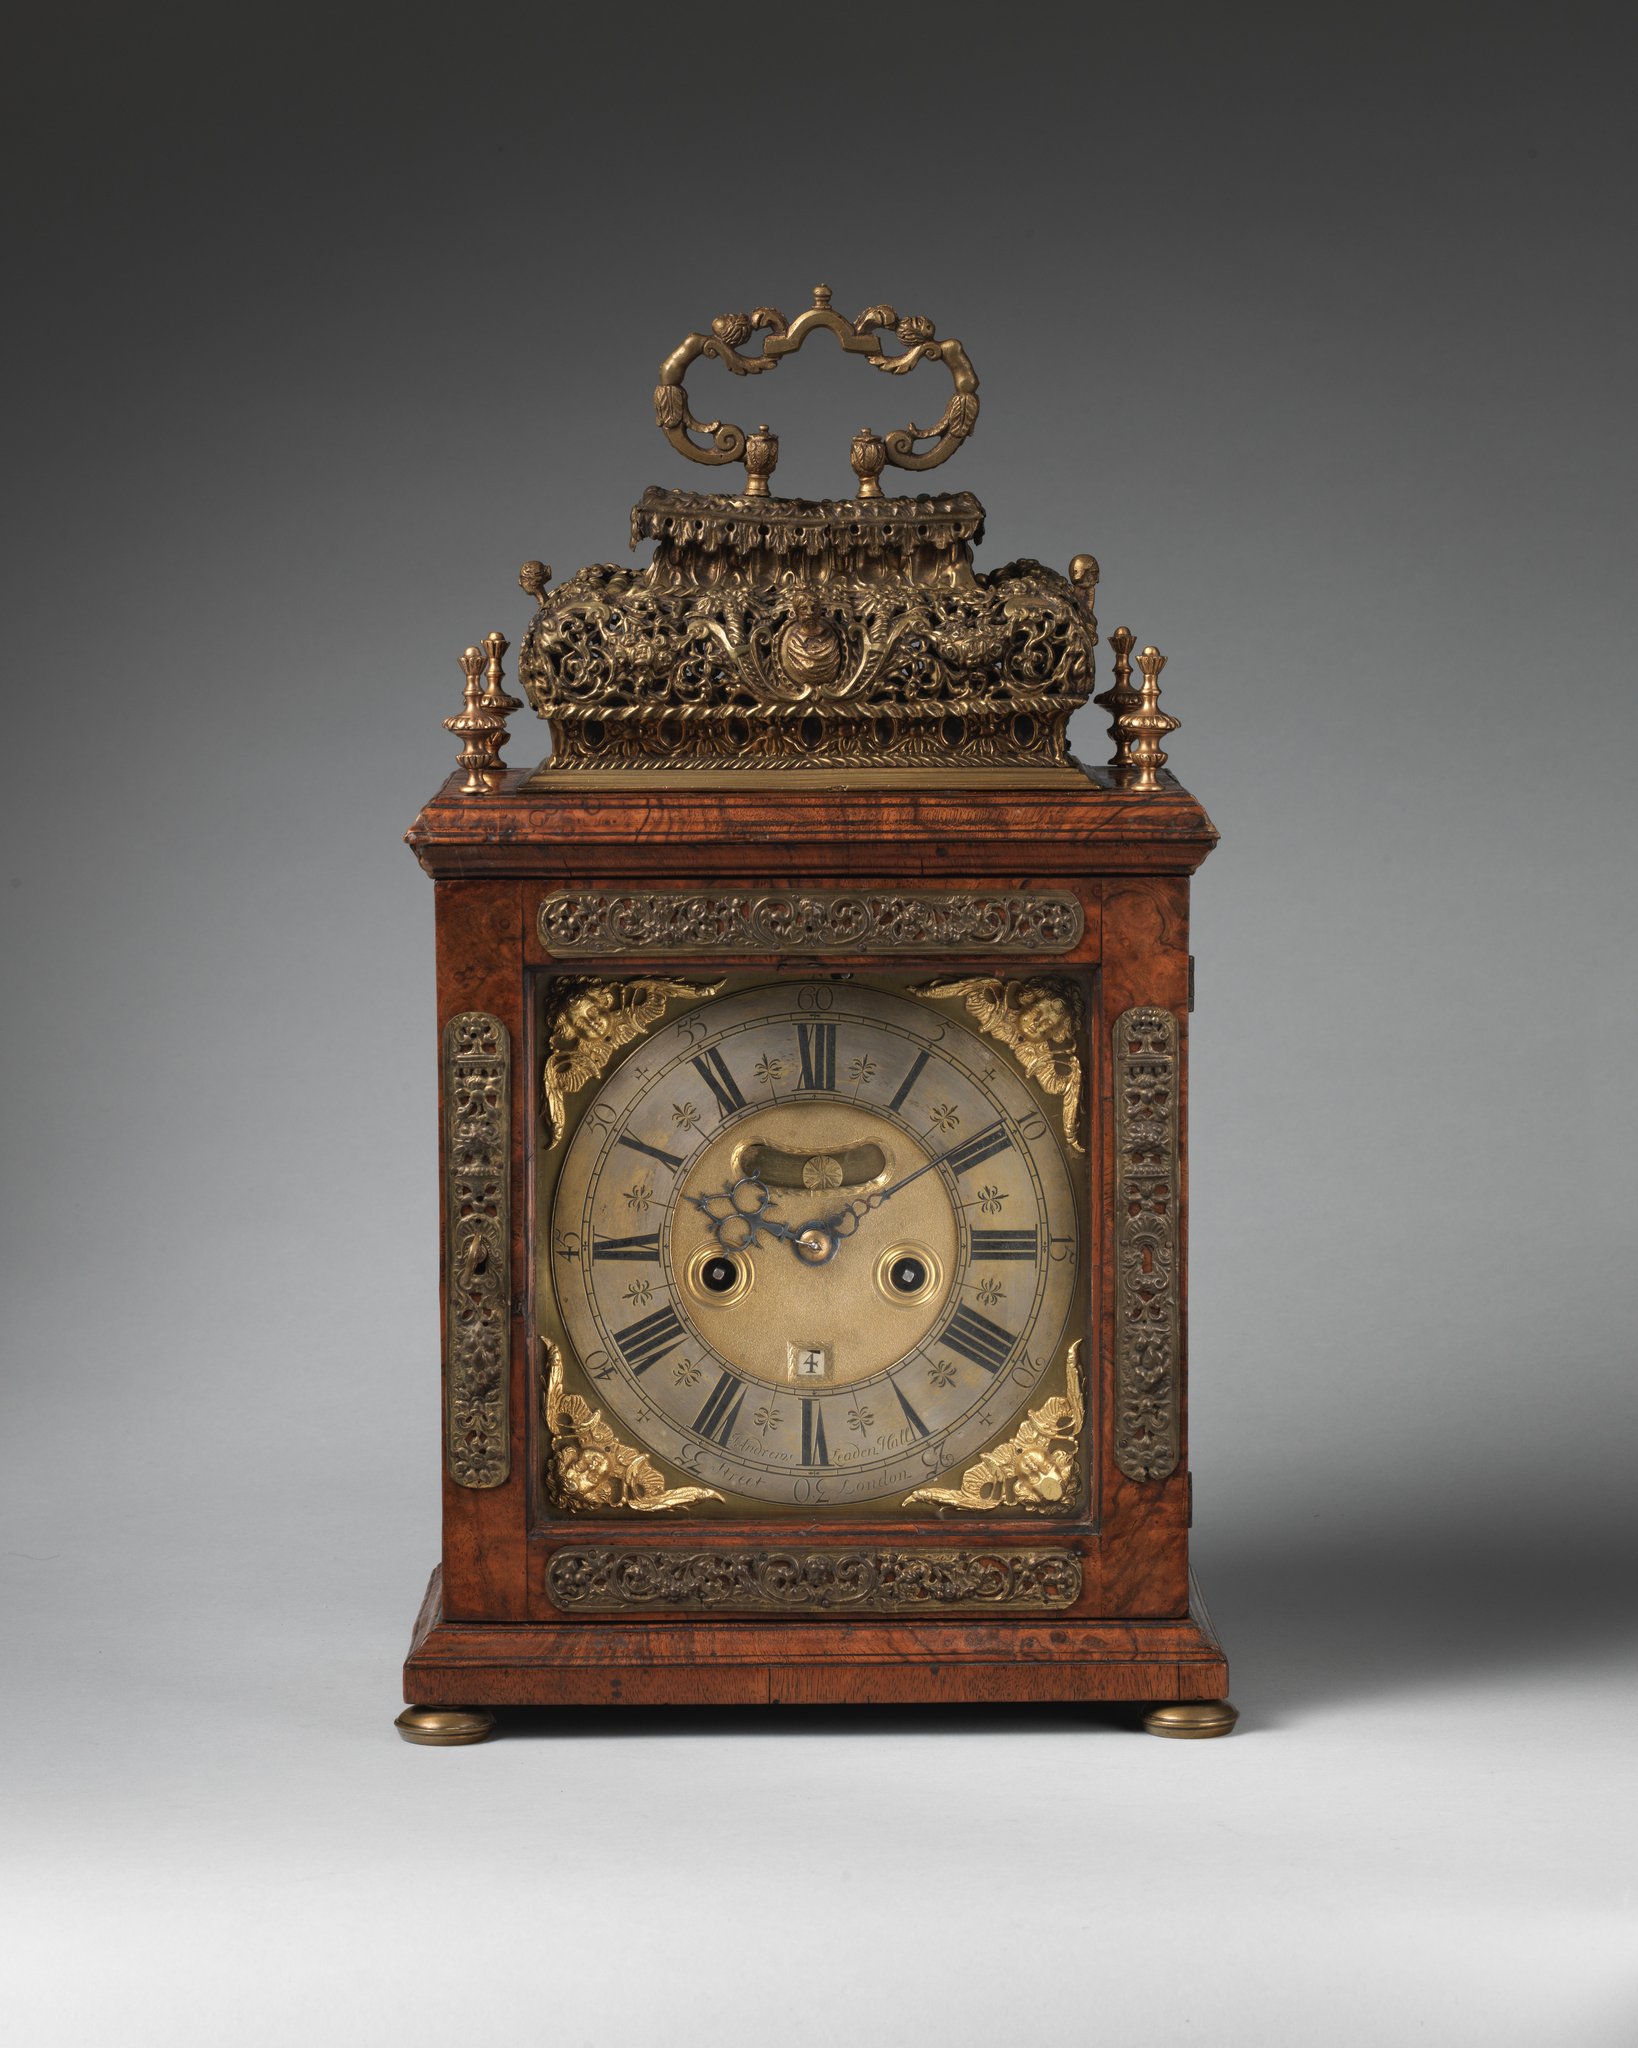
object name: table or bracket clock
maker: john andrews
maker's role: maker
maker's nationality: british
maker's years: 1680-1708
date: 1690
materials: gilt brass, steel, wood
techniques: veneering